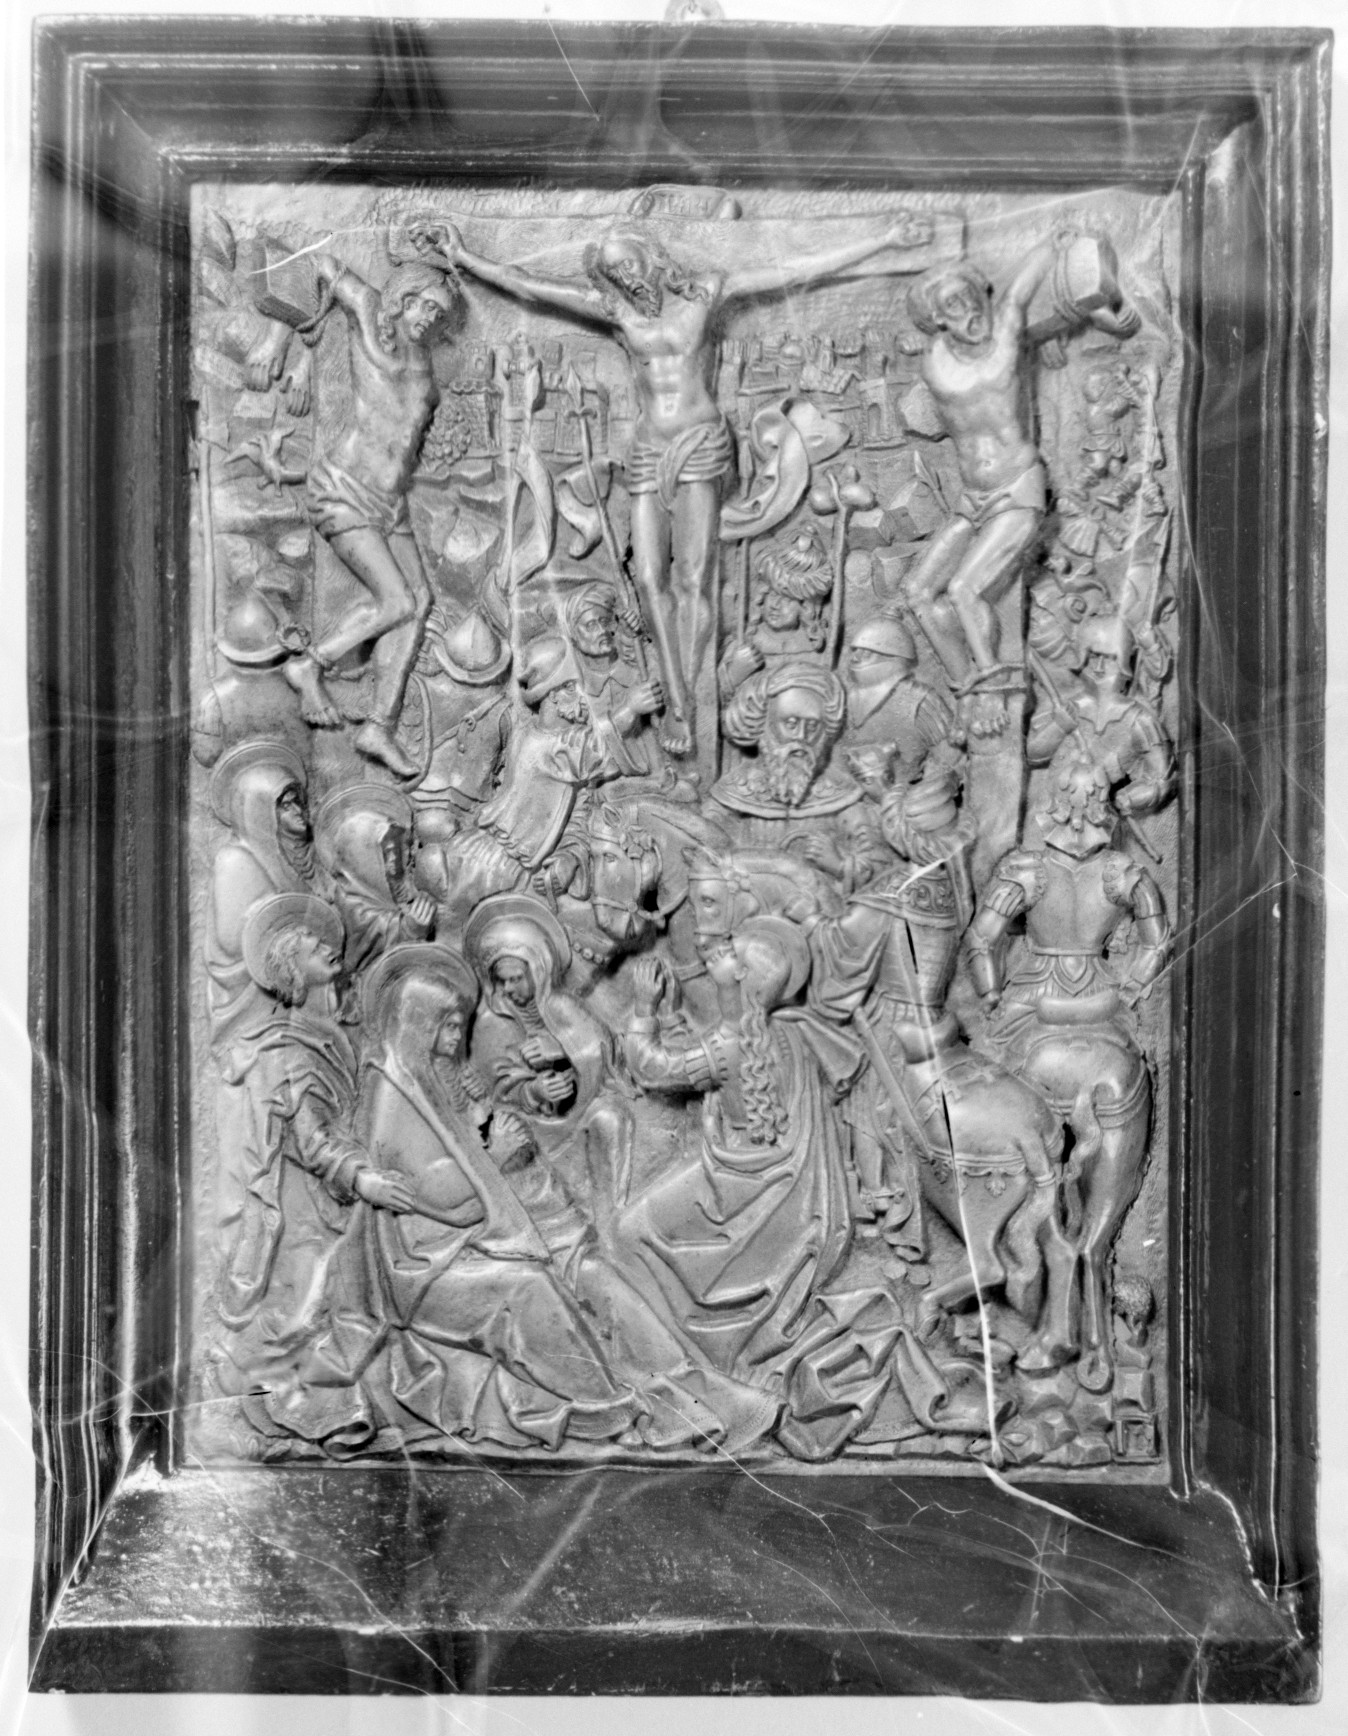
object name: picture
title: Mount Calvary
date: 1520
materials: copper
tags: soldiers,women,jesus,crucifixion